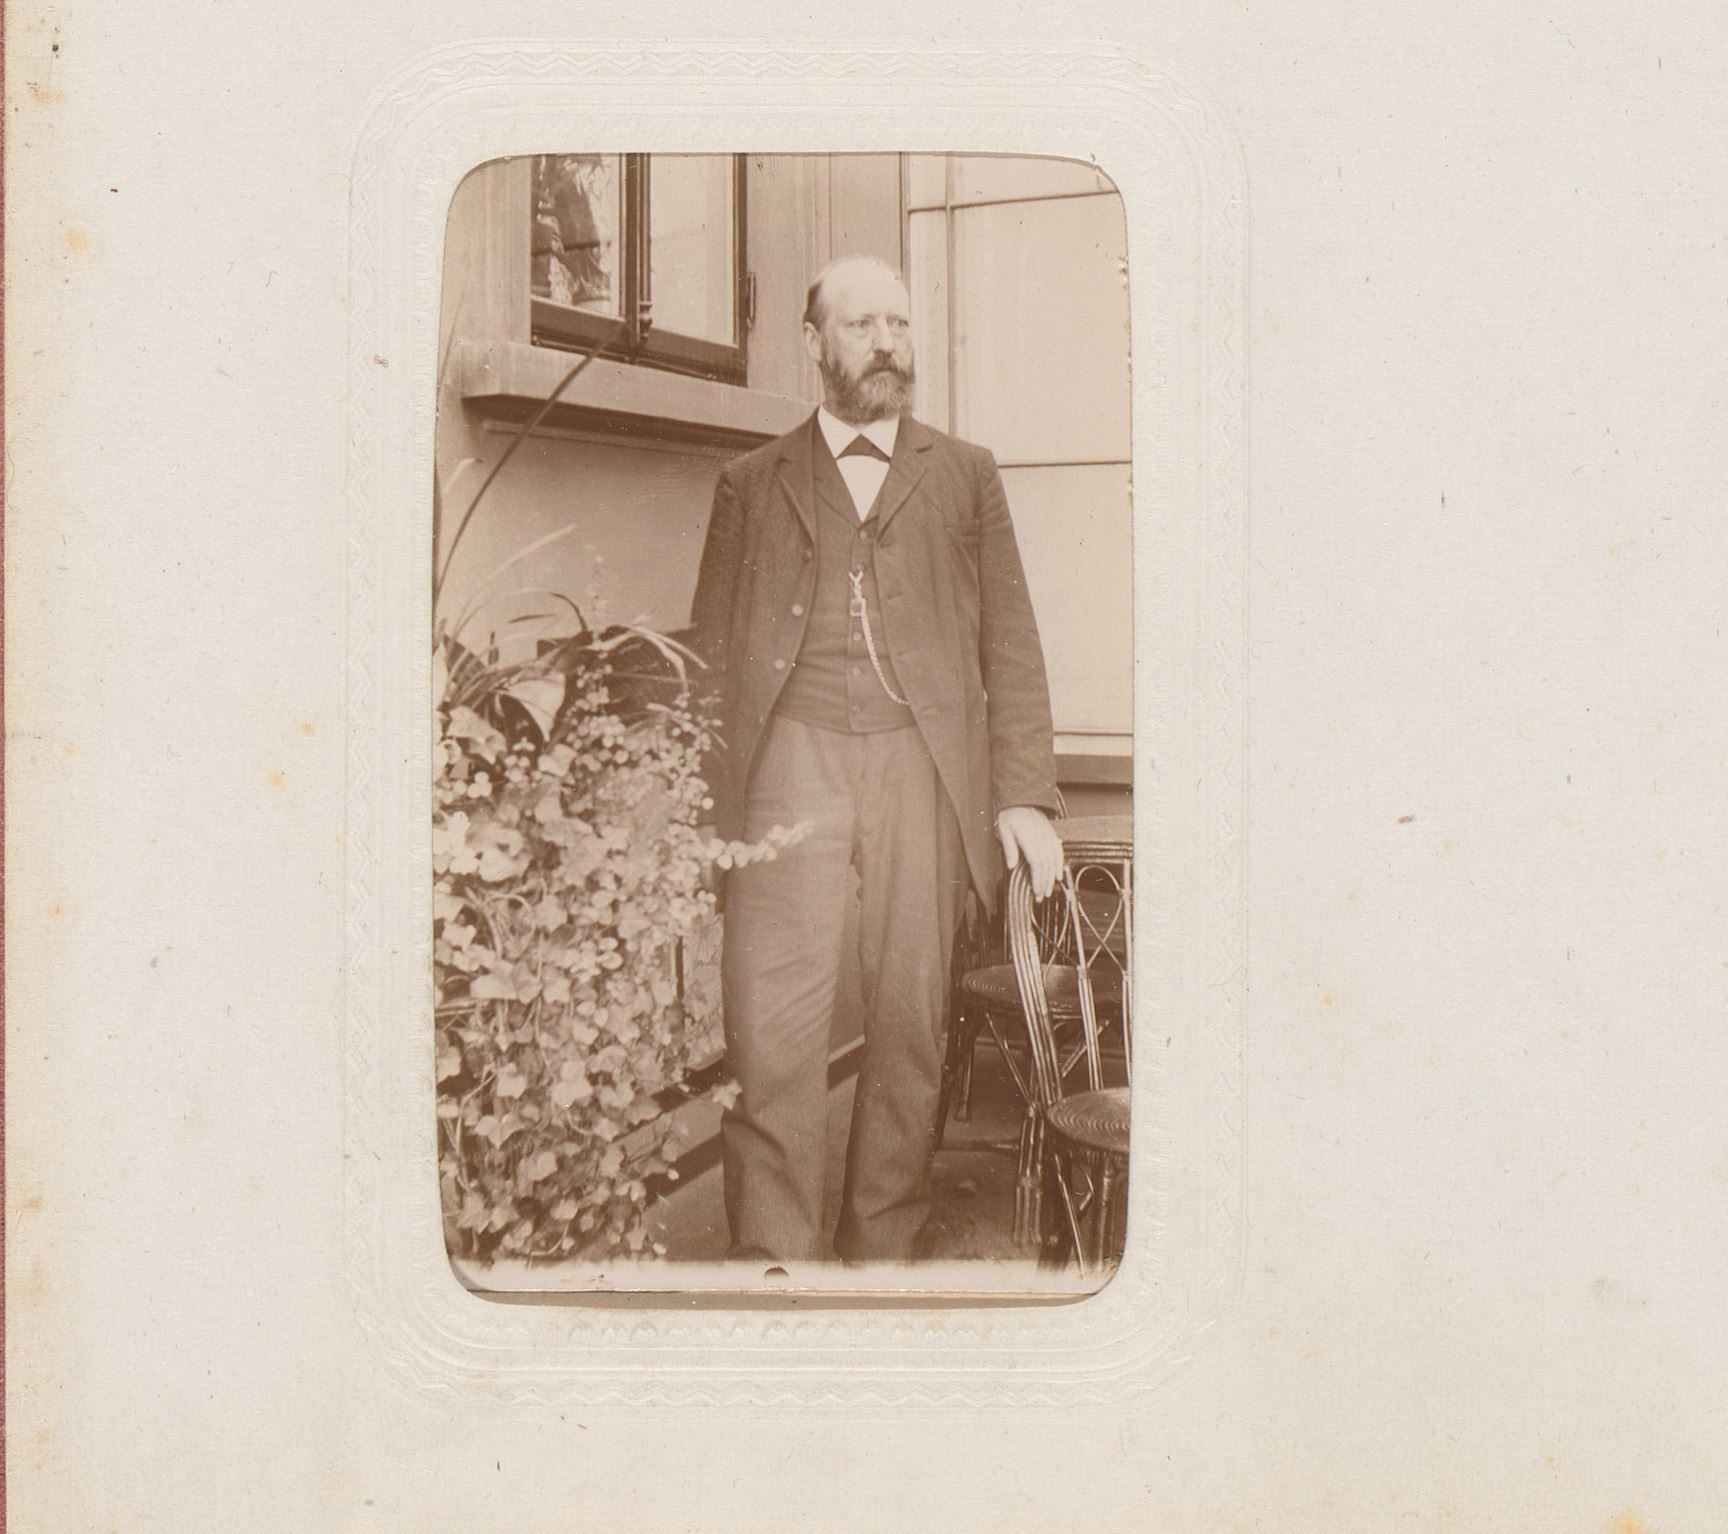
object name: carte de visite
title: Portret van een man, staand bij een stoel voor een huis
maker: Anonymous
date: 1880-1920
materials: cardboard, photographic support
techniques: collodion silver print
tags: historical persons, civic architecture; edifices; dwellings, chair